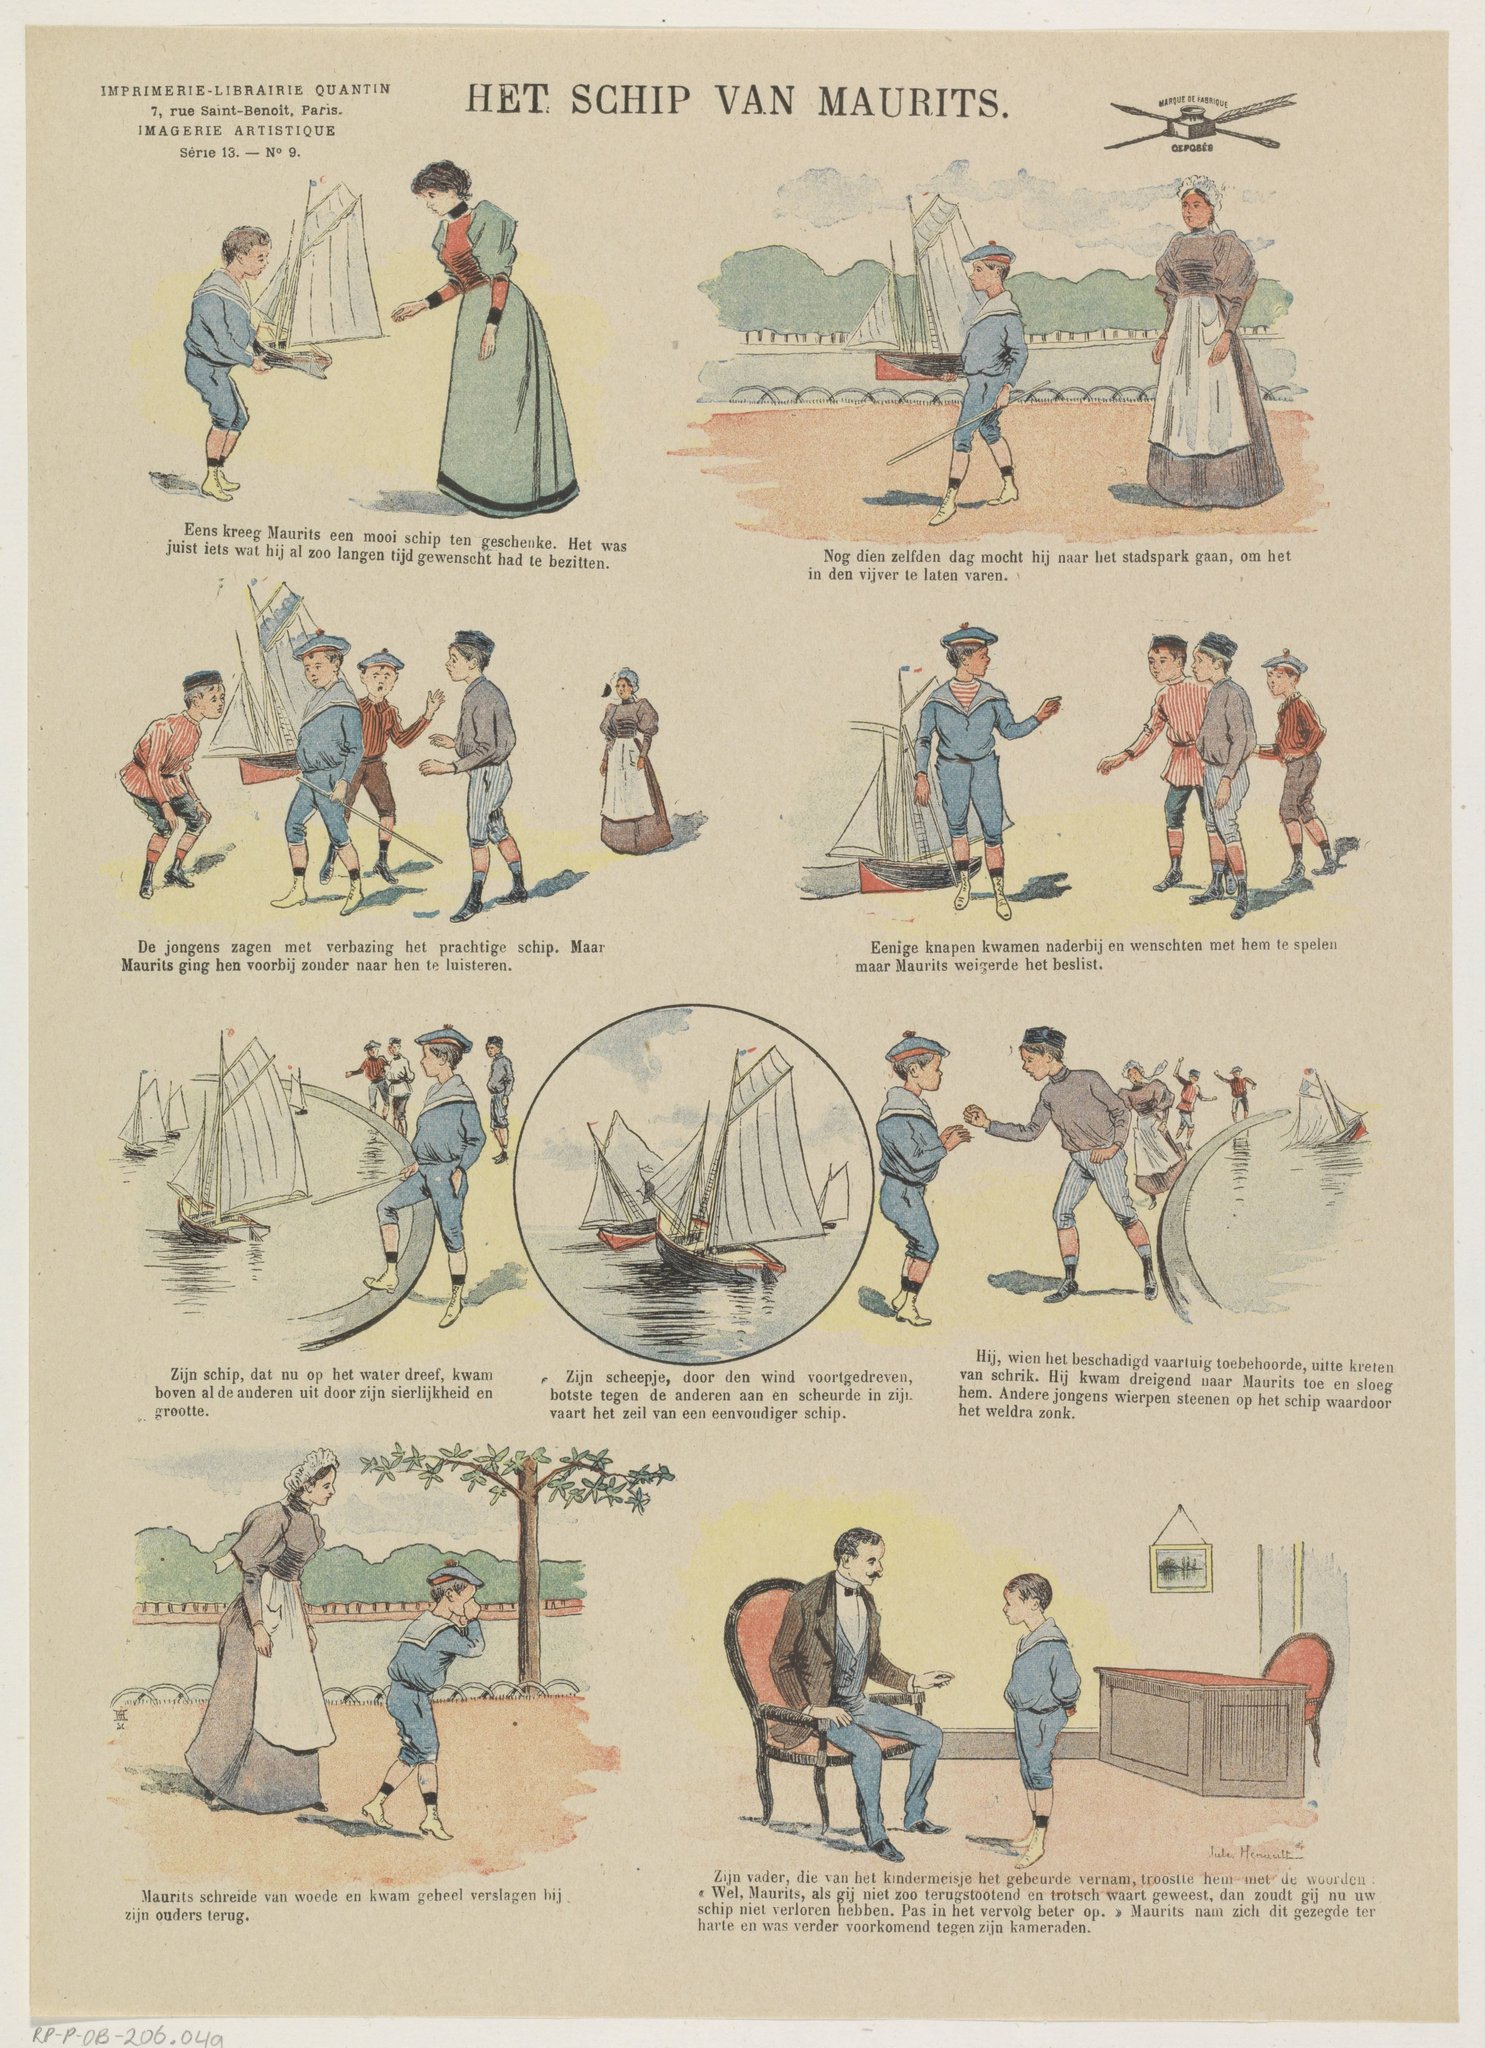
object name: popular print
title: Het schip van Maurits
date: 1876-1890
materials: paper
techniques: lithograph, letterpress printing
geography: paris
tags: sailing-ship, sailing-boat, children's games and plays, tales and fairy tales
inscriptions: collector's mark: Lugt 2760, : ‘marque de fabrique / deposée’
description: Blad met 9 voorstellingen van de kleine Maurits die met zijn nieuwe schip gaat varen. Onder elke afbeelding een onderschrift. Genummerd linksboven: Série 13. - No. 9.